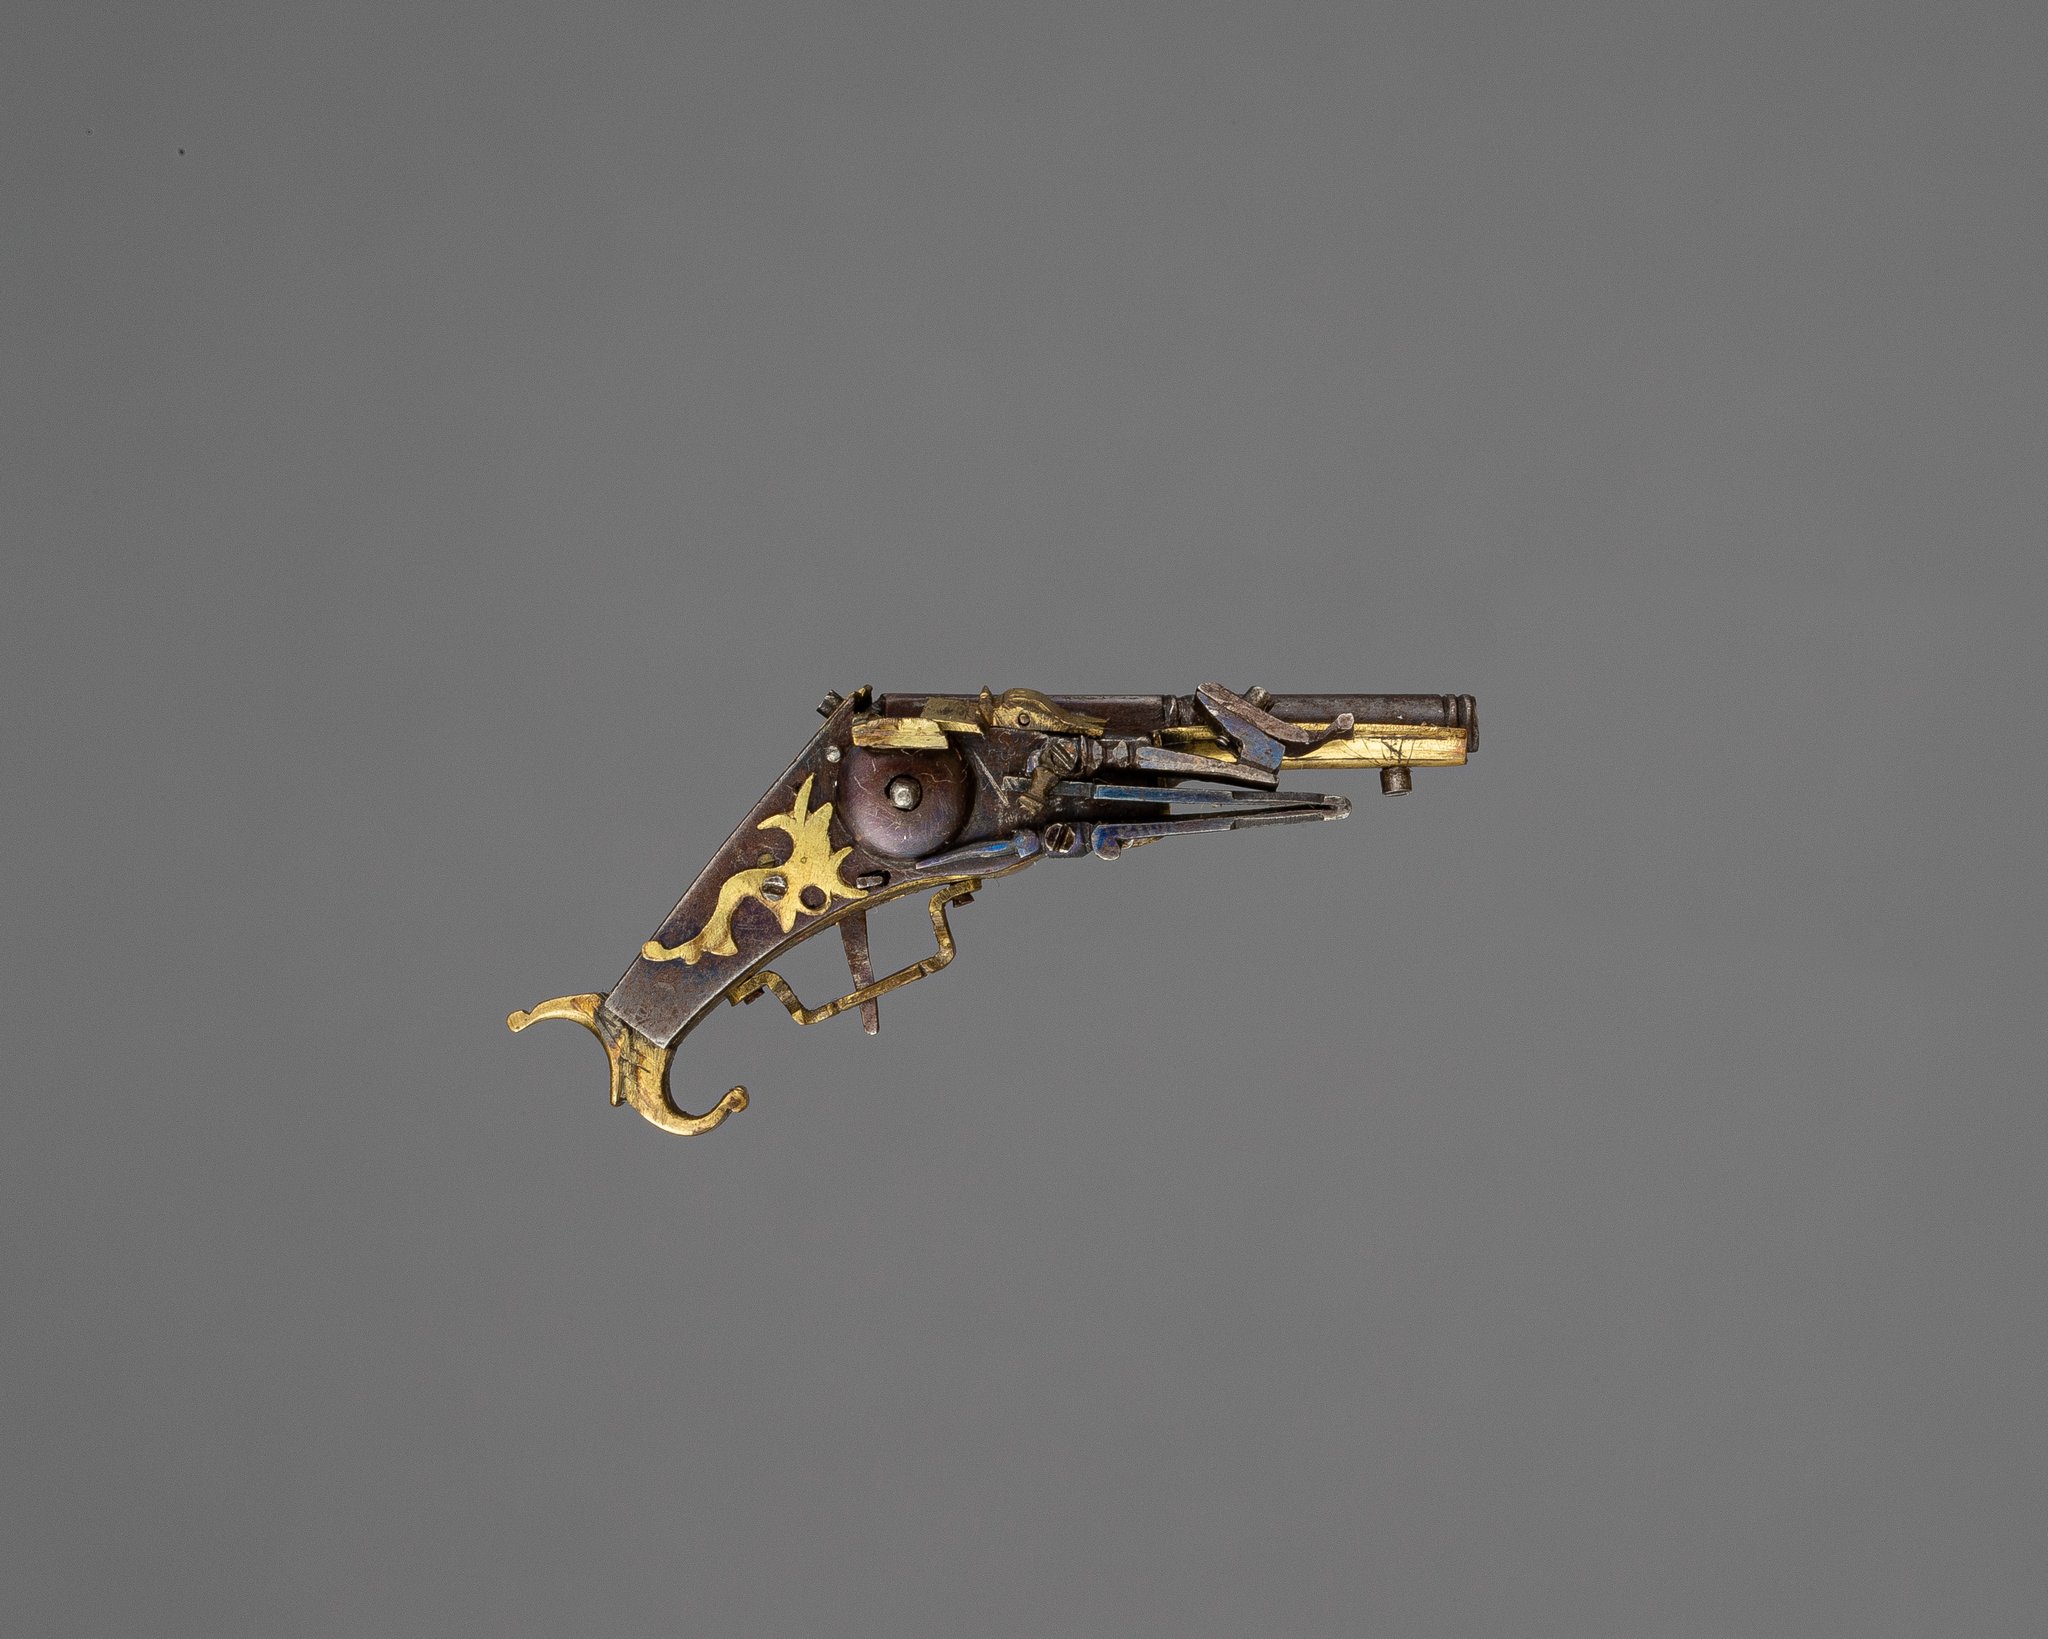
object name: pair of wheellock pistol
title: Model of Wheellock Pistol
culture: german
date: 1550-1600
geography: germany